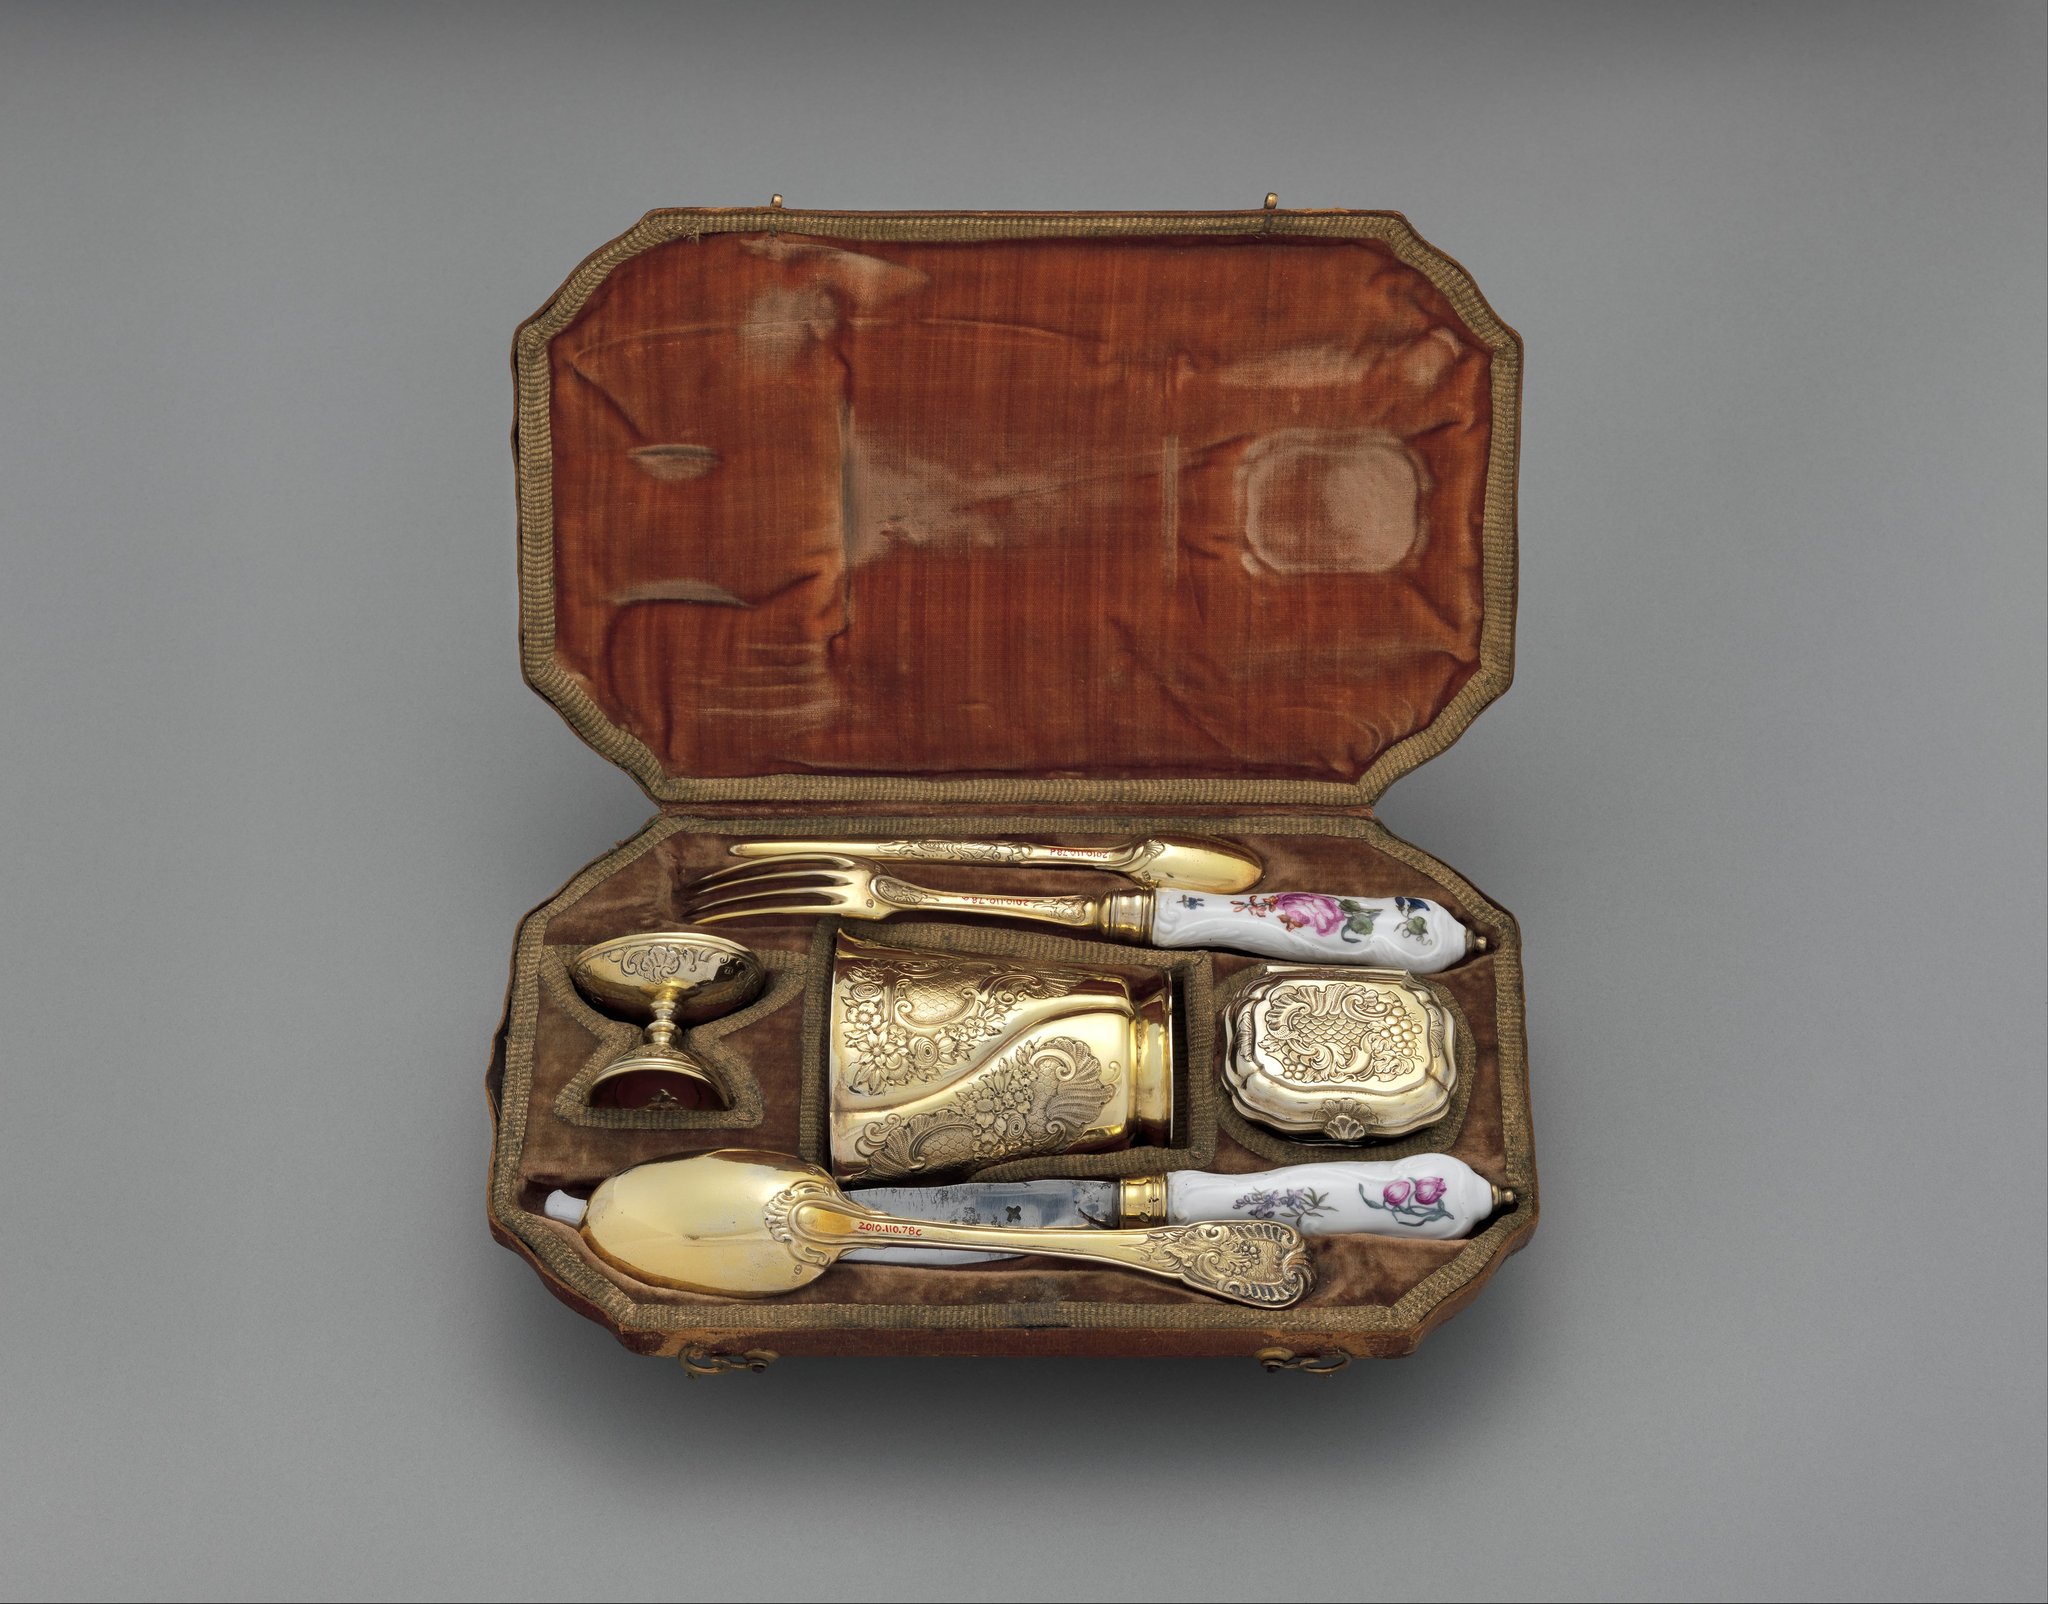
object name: traveling set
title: Traveling set in leather case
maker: johann ludwig laminit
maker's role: maker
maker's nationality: german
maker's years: 1696-1752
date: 1745-1750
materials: gilt silver, leather, porcelain, steel, velvet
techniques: tooling